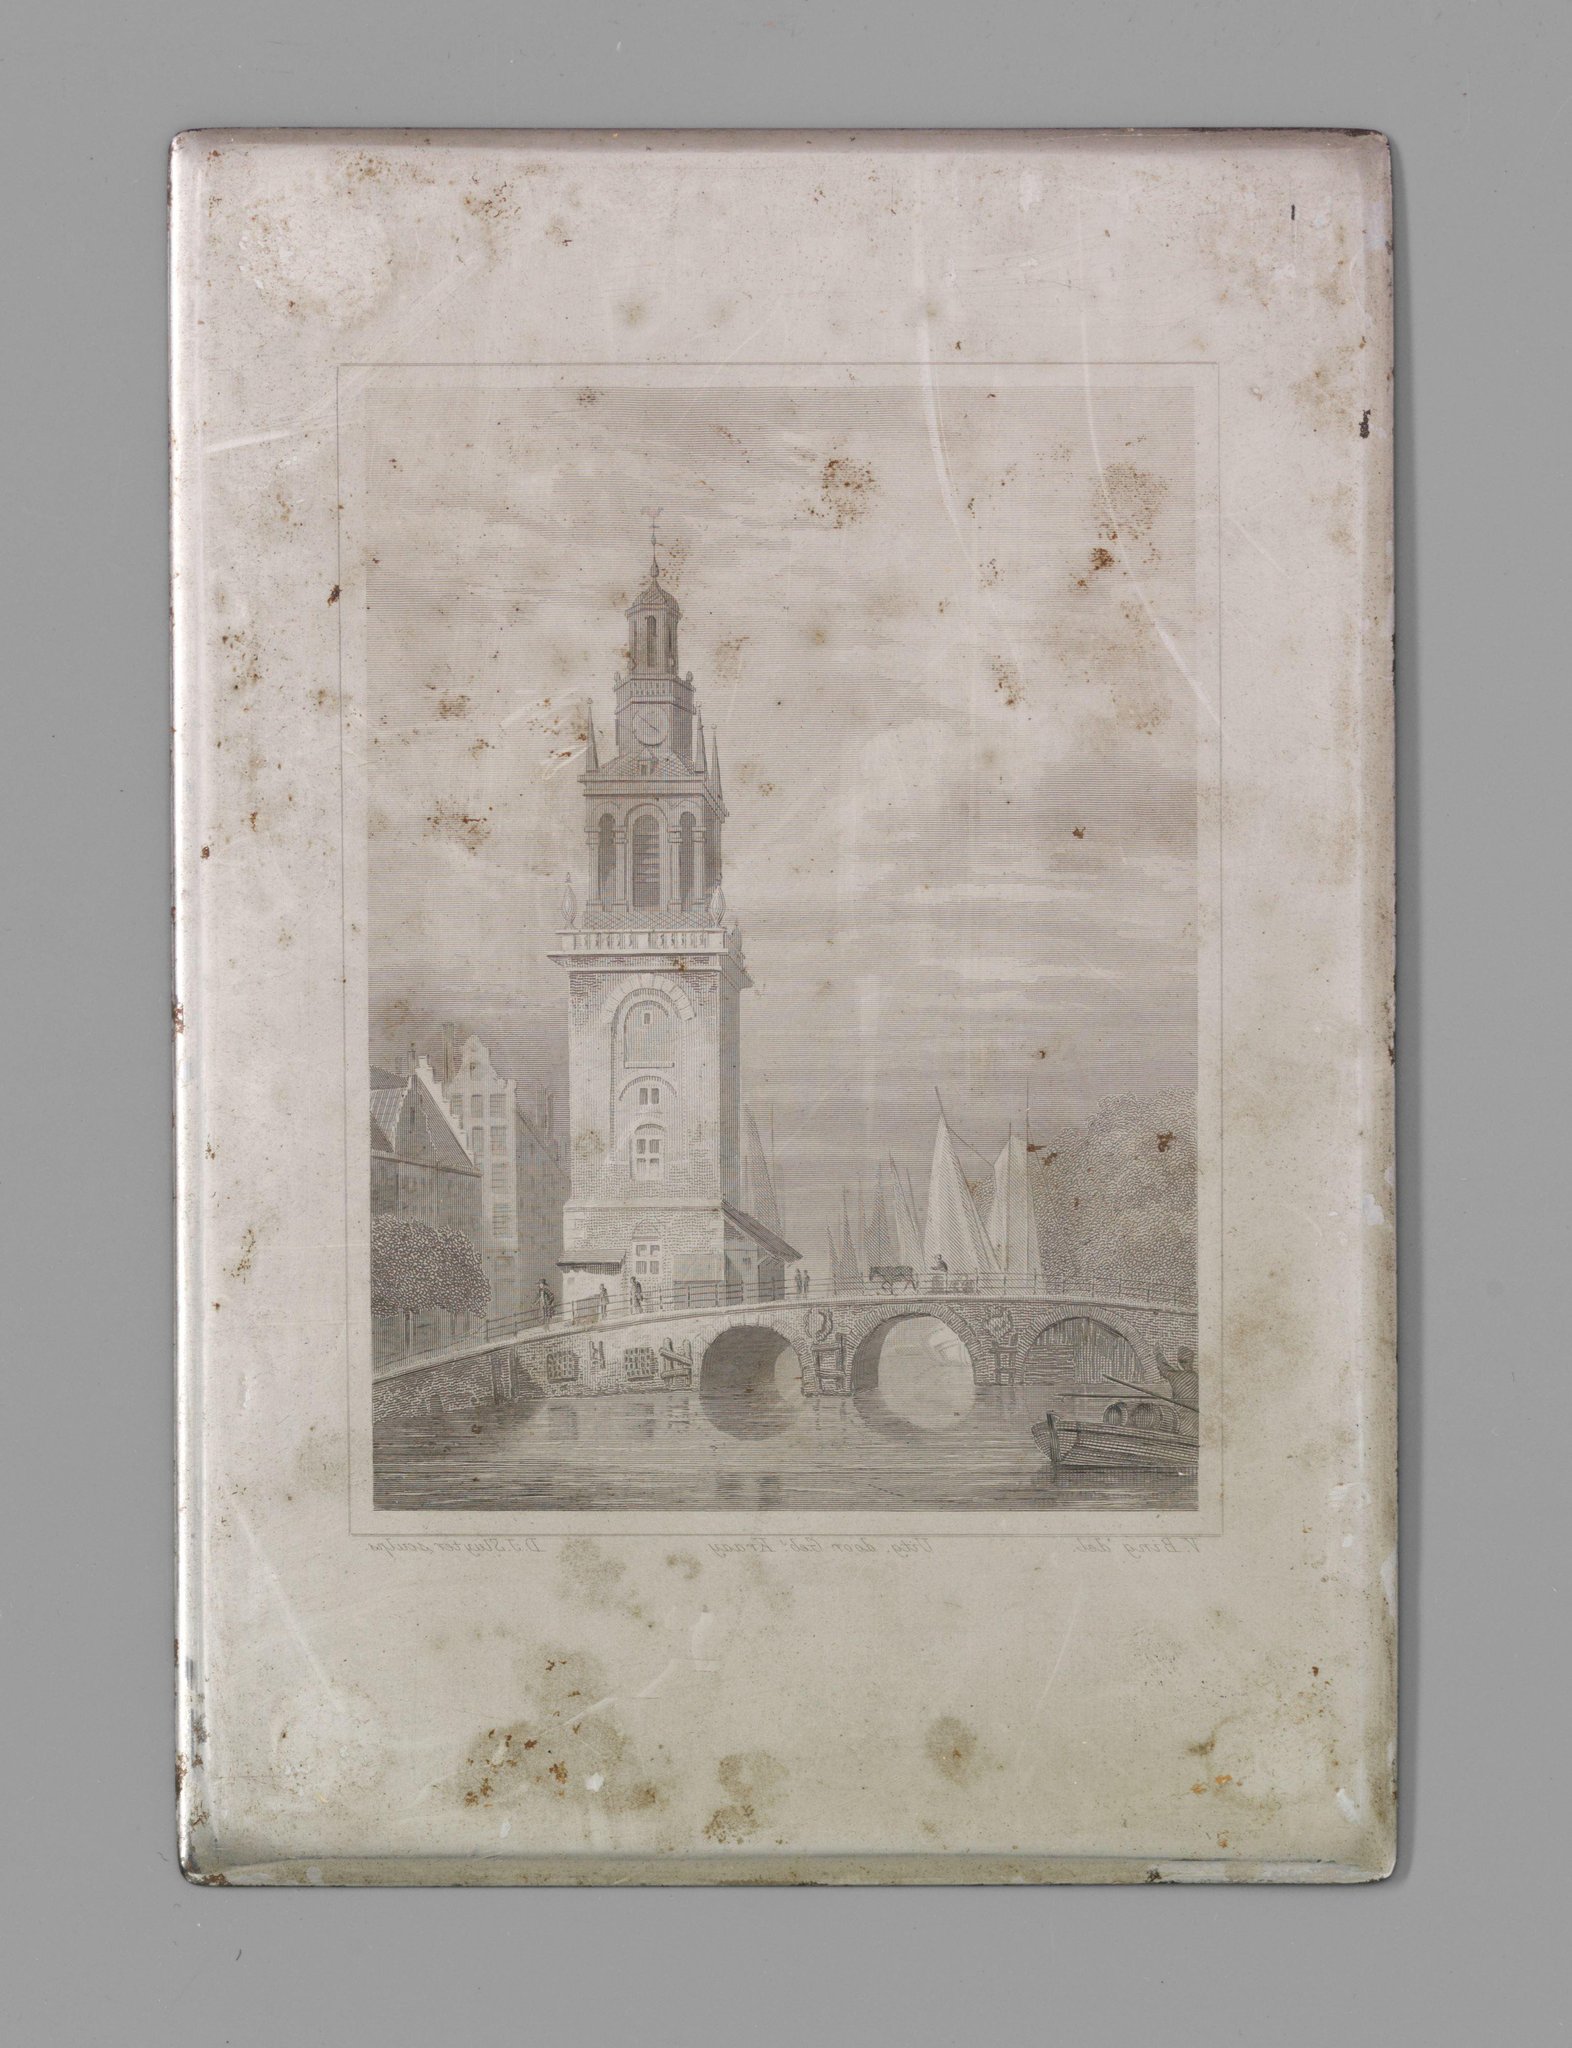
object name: staalplaat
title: Gezicht op de Torenbrug met de Jan Rodenpoortstoren aan het Singel te Amsterdam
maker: dirk jurriaan sluyter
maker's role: draughtsman, print maker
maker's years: 1811-1886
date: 1822-1870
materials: steel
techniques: engraving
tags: jan roodenpoortstoren, singel